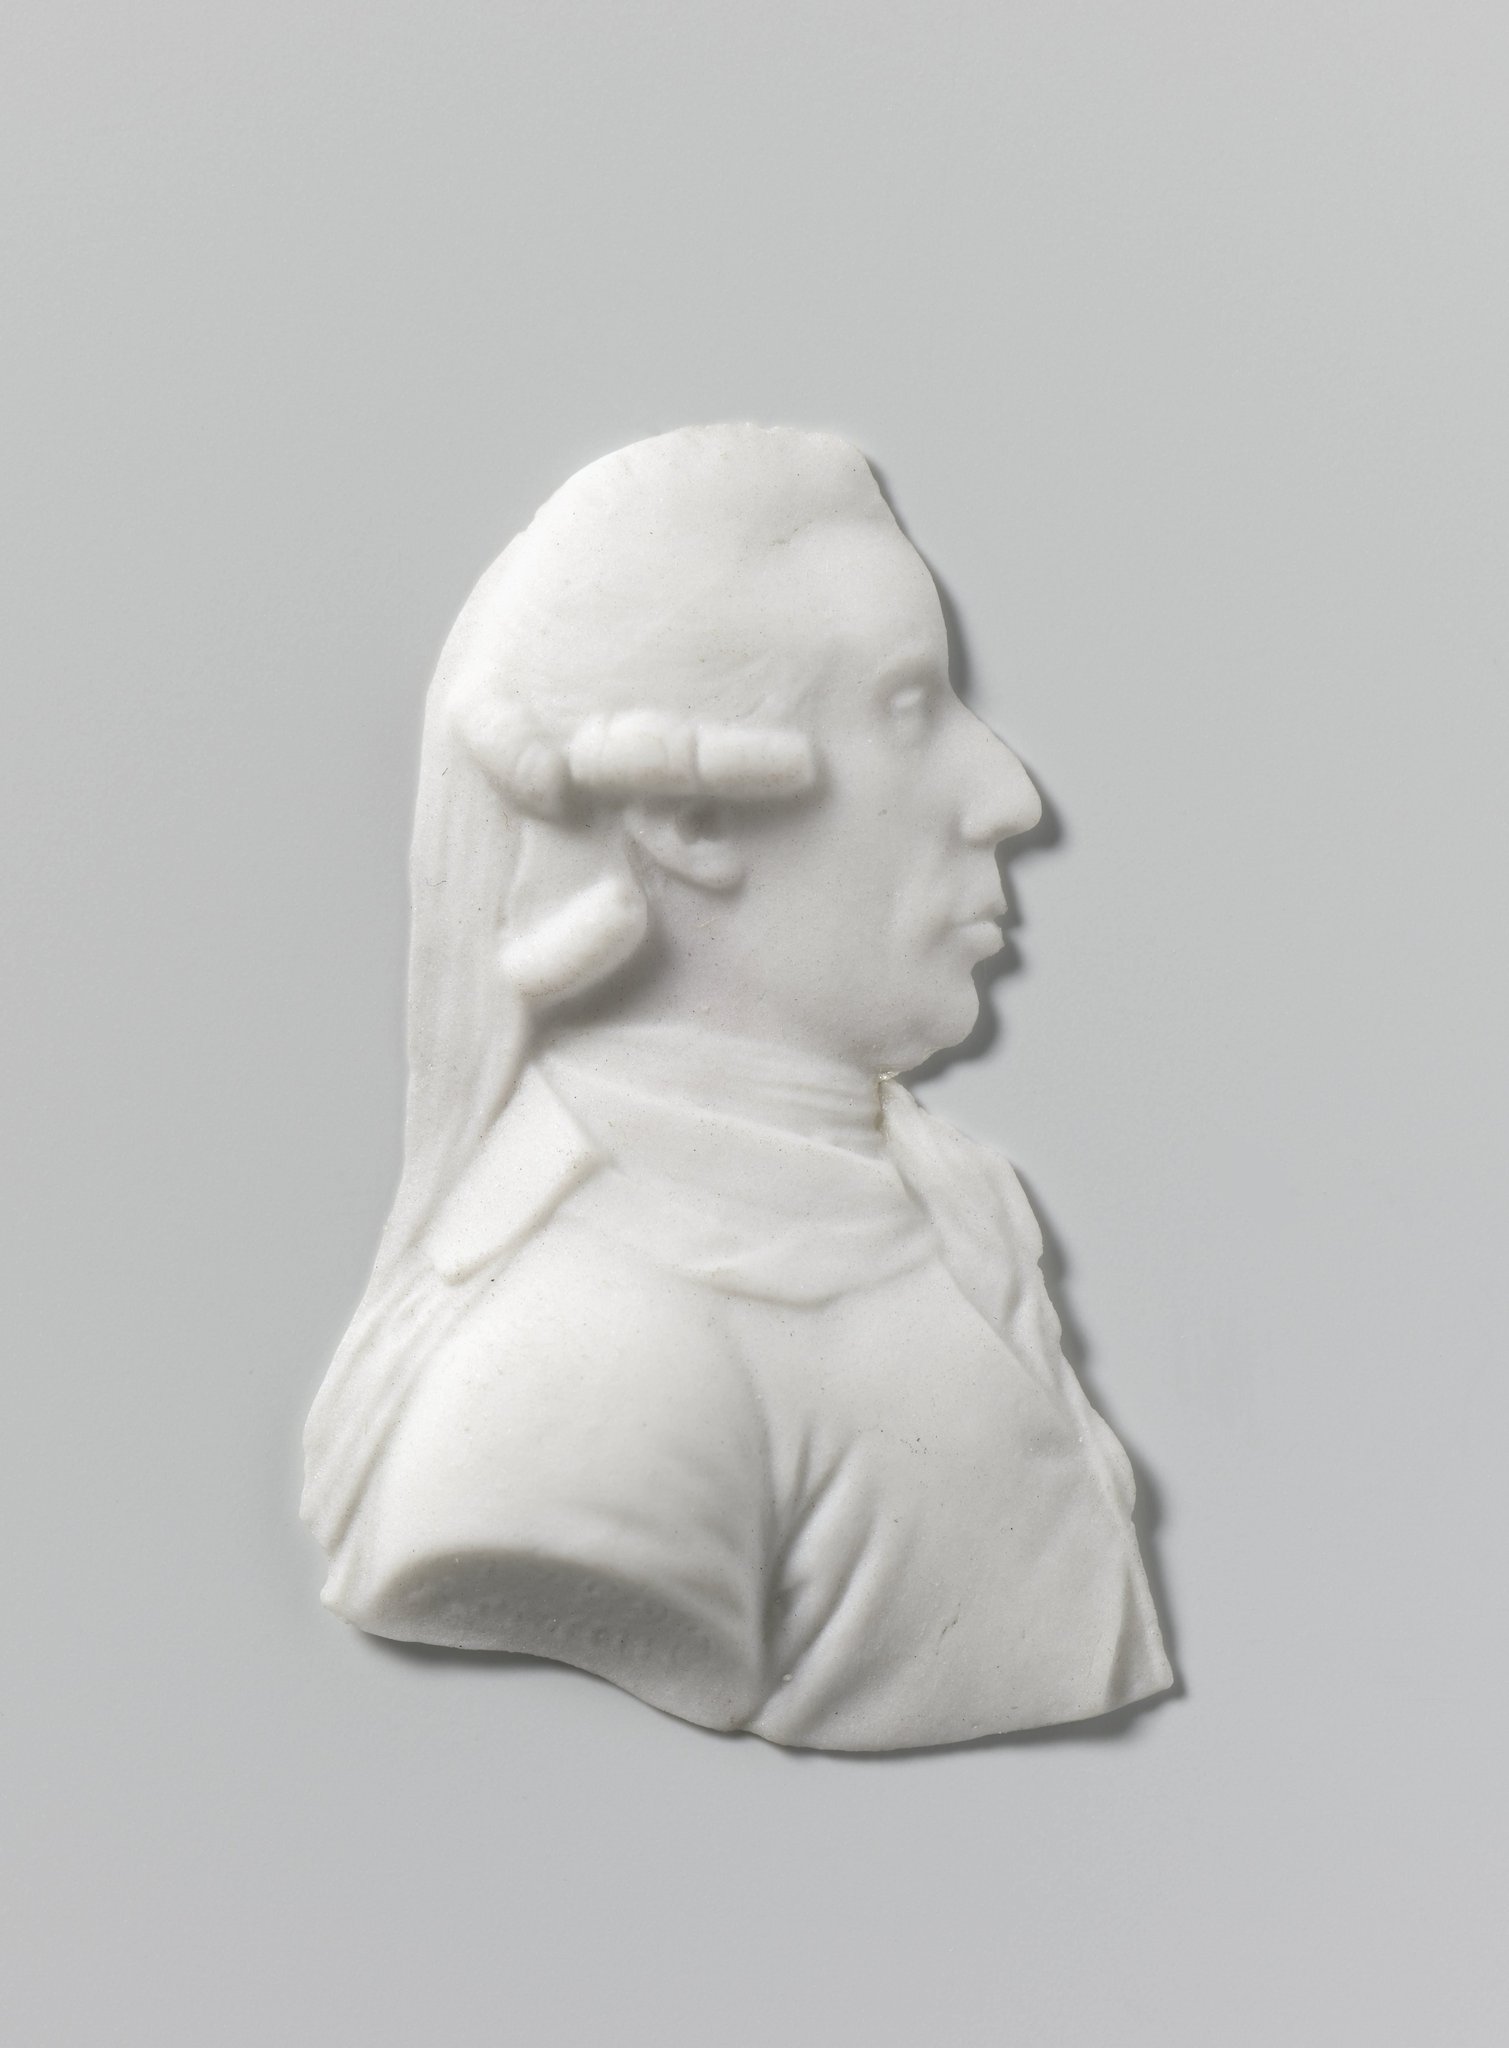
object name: relief sculpture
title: Portrait of J. Sylvain Bailly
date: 1789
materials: porcelain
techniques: firing, forming, relief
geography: valenciennes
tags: paris, politician, mayor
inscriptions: signature and date: ‘1789 // Renaud’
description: Portret van porselein in biscuit. Het portret toont J. Sylvain Bailly (1736-1793), in 1789 burgemeester van Parijs. Gesigneerd en gedateerd met '1789 Renaud'.